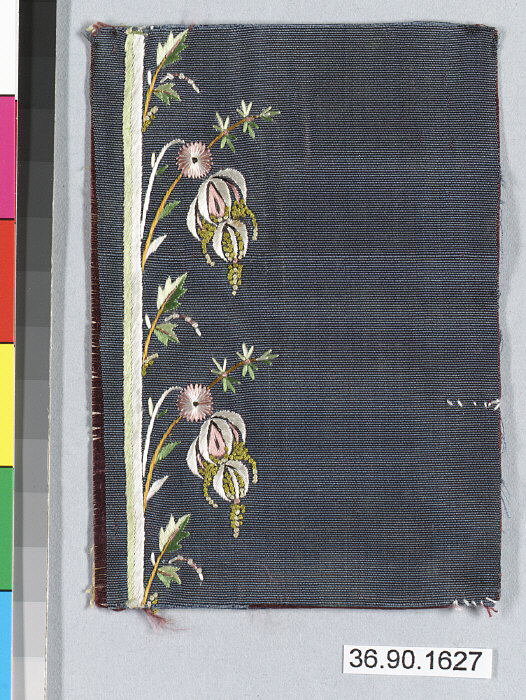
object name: sample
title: Embroidery sample for a man’s suit or waistcoat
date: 1785-1815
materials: silk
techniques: embroidery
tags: flowers